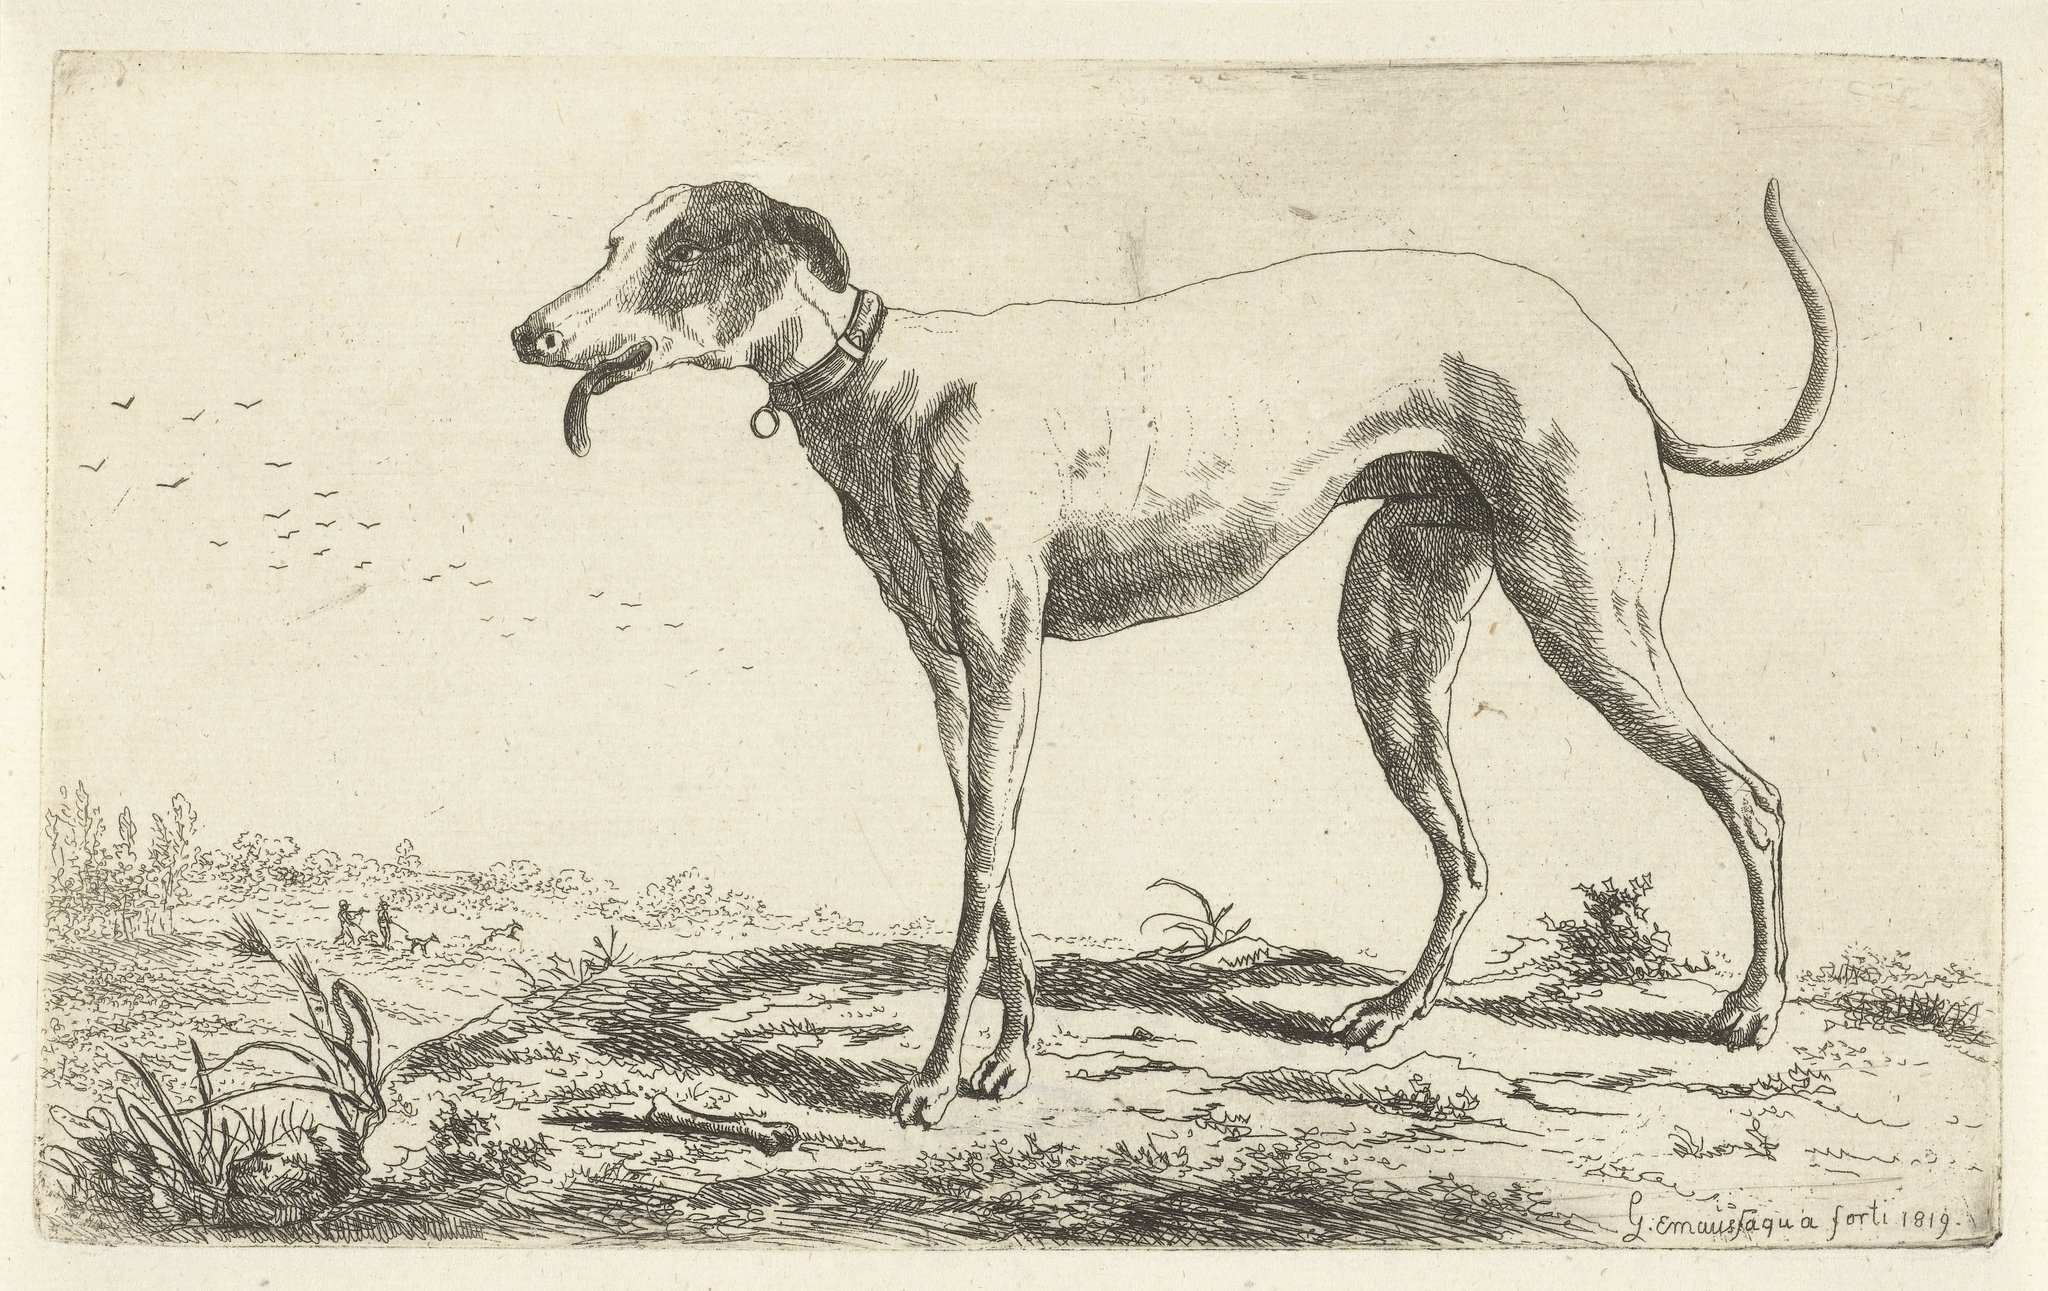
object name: print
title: Hazewindhond Diana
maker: gerardus emaus de micault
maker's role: draughtsman, print maker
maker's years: 1798-1863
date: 1819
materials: paper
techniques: etching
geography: netherlands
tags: dog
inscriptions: collector's mark: Lugt 2228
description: Een hazewindhond met halsband en de tong uit de bek staat bij zijn bot.